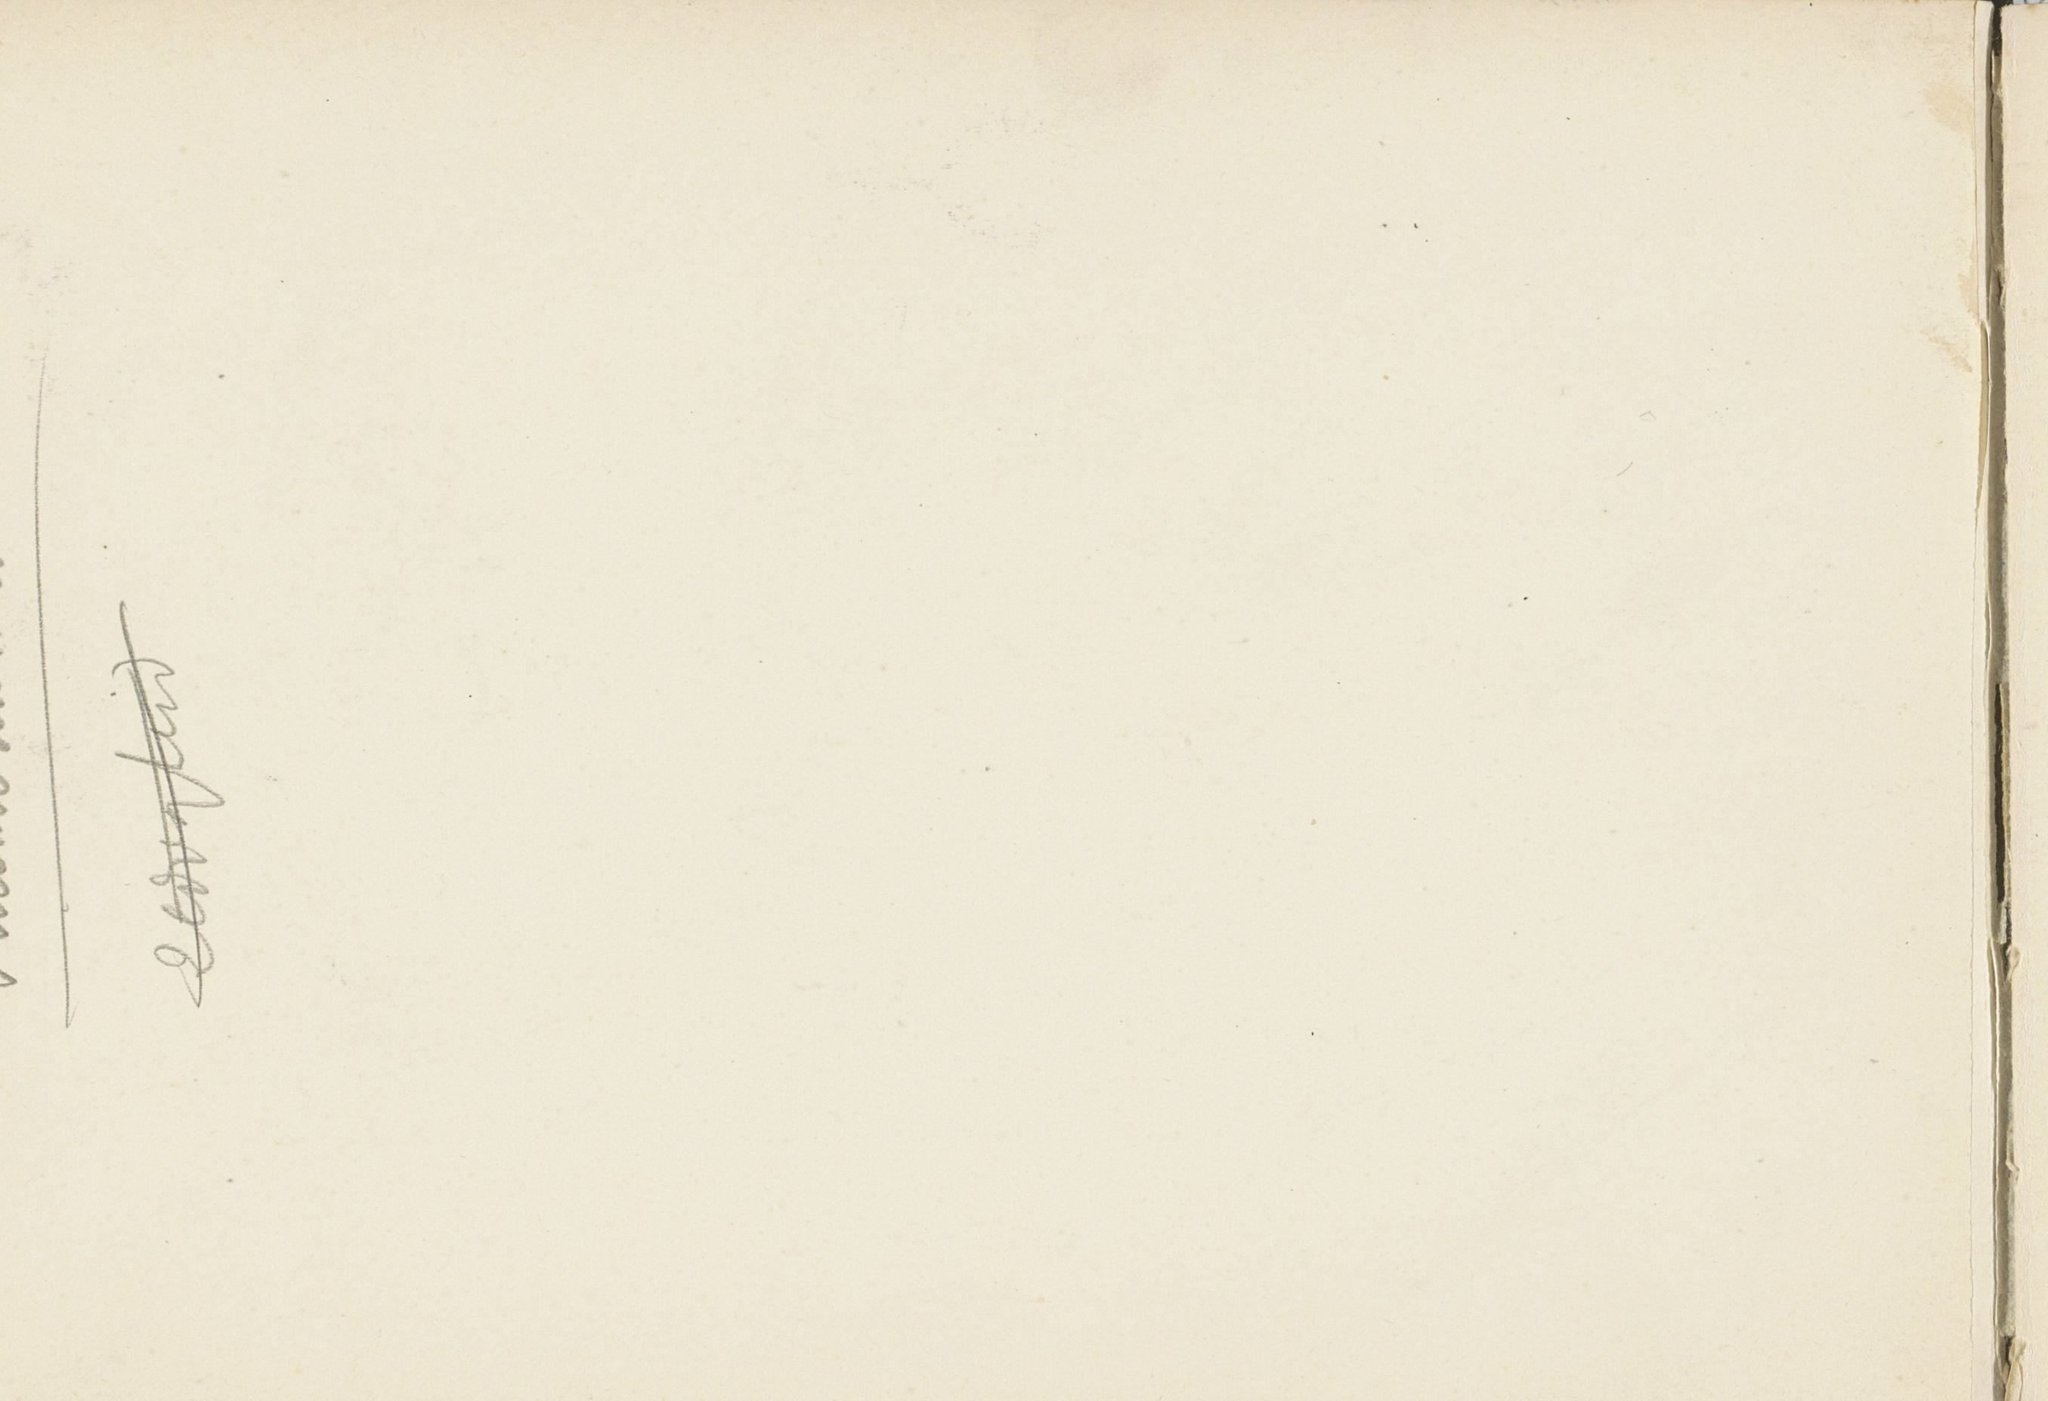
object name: sketchbook leaf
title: Notitie over Venus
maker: antoon derkinderen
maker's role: draughtsman, painter, print maker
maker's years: 1859-1925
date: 1900-1903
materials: paper, pencil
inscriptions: annotation: ‘Venus - Vreugde - Schoonheid-/ Vruchtbaarheid’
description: Blad 7 verso uit een schetsboek met 45 bladen.